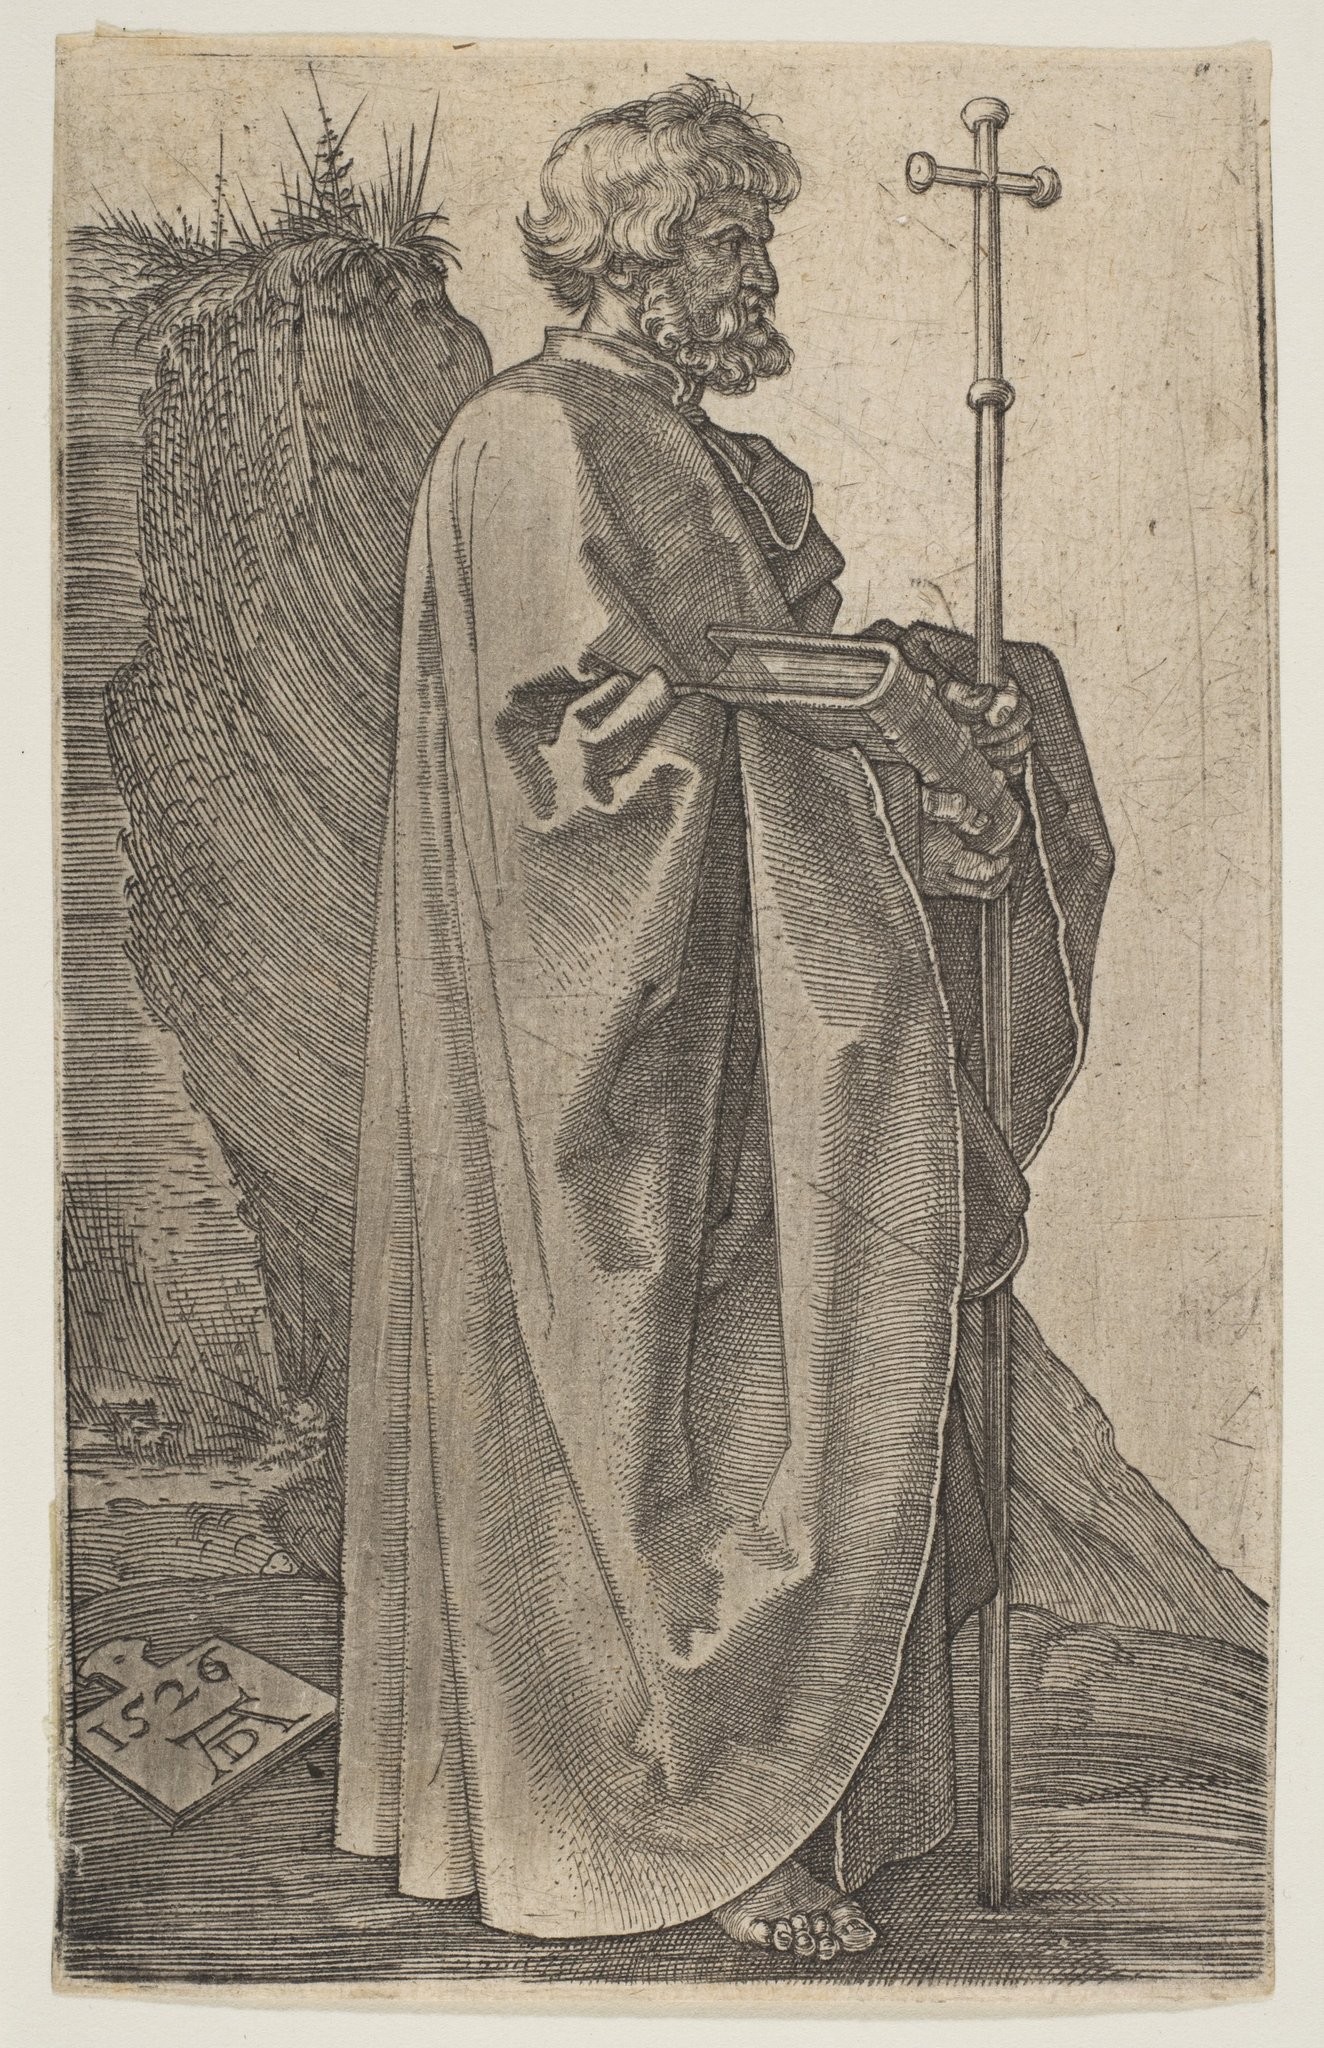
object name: print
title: Saint Philip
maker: albrecht dürer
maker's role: artist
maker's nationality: german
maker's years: 1471-1528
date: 1523-1526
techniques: engraving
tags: books,cross,saints